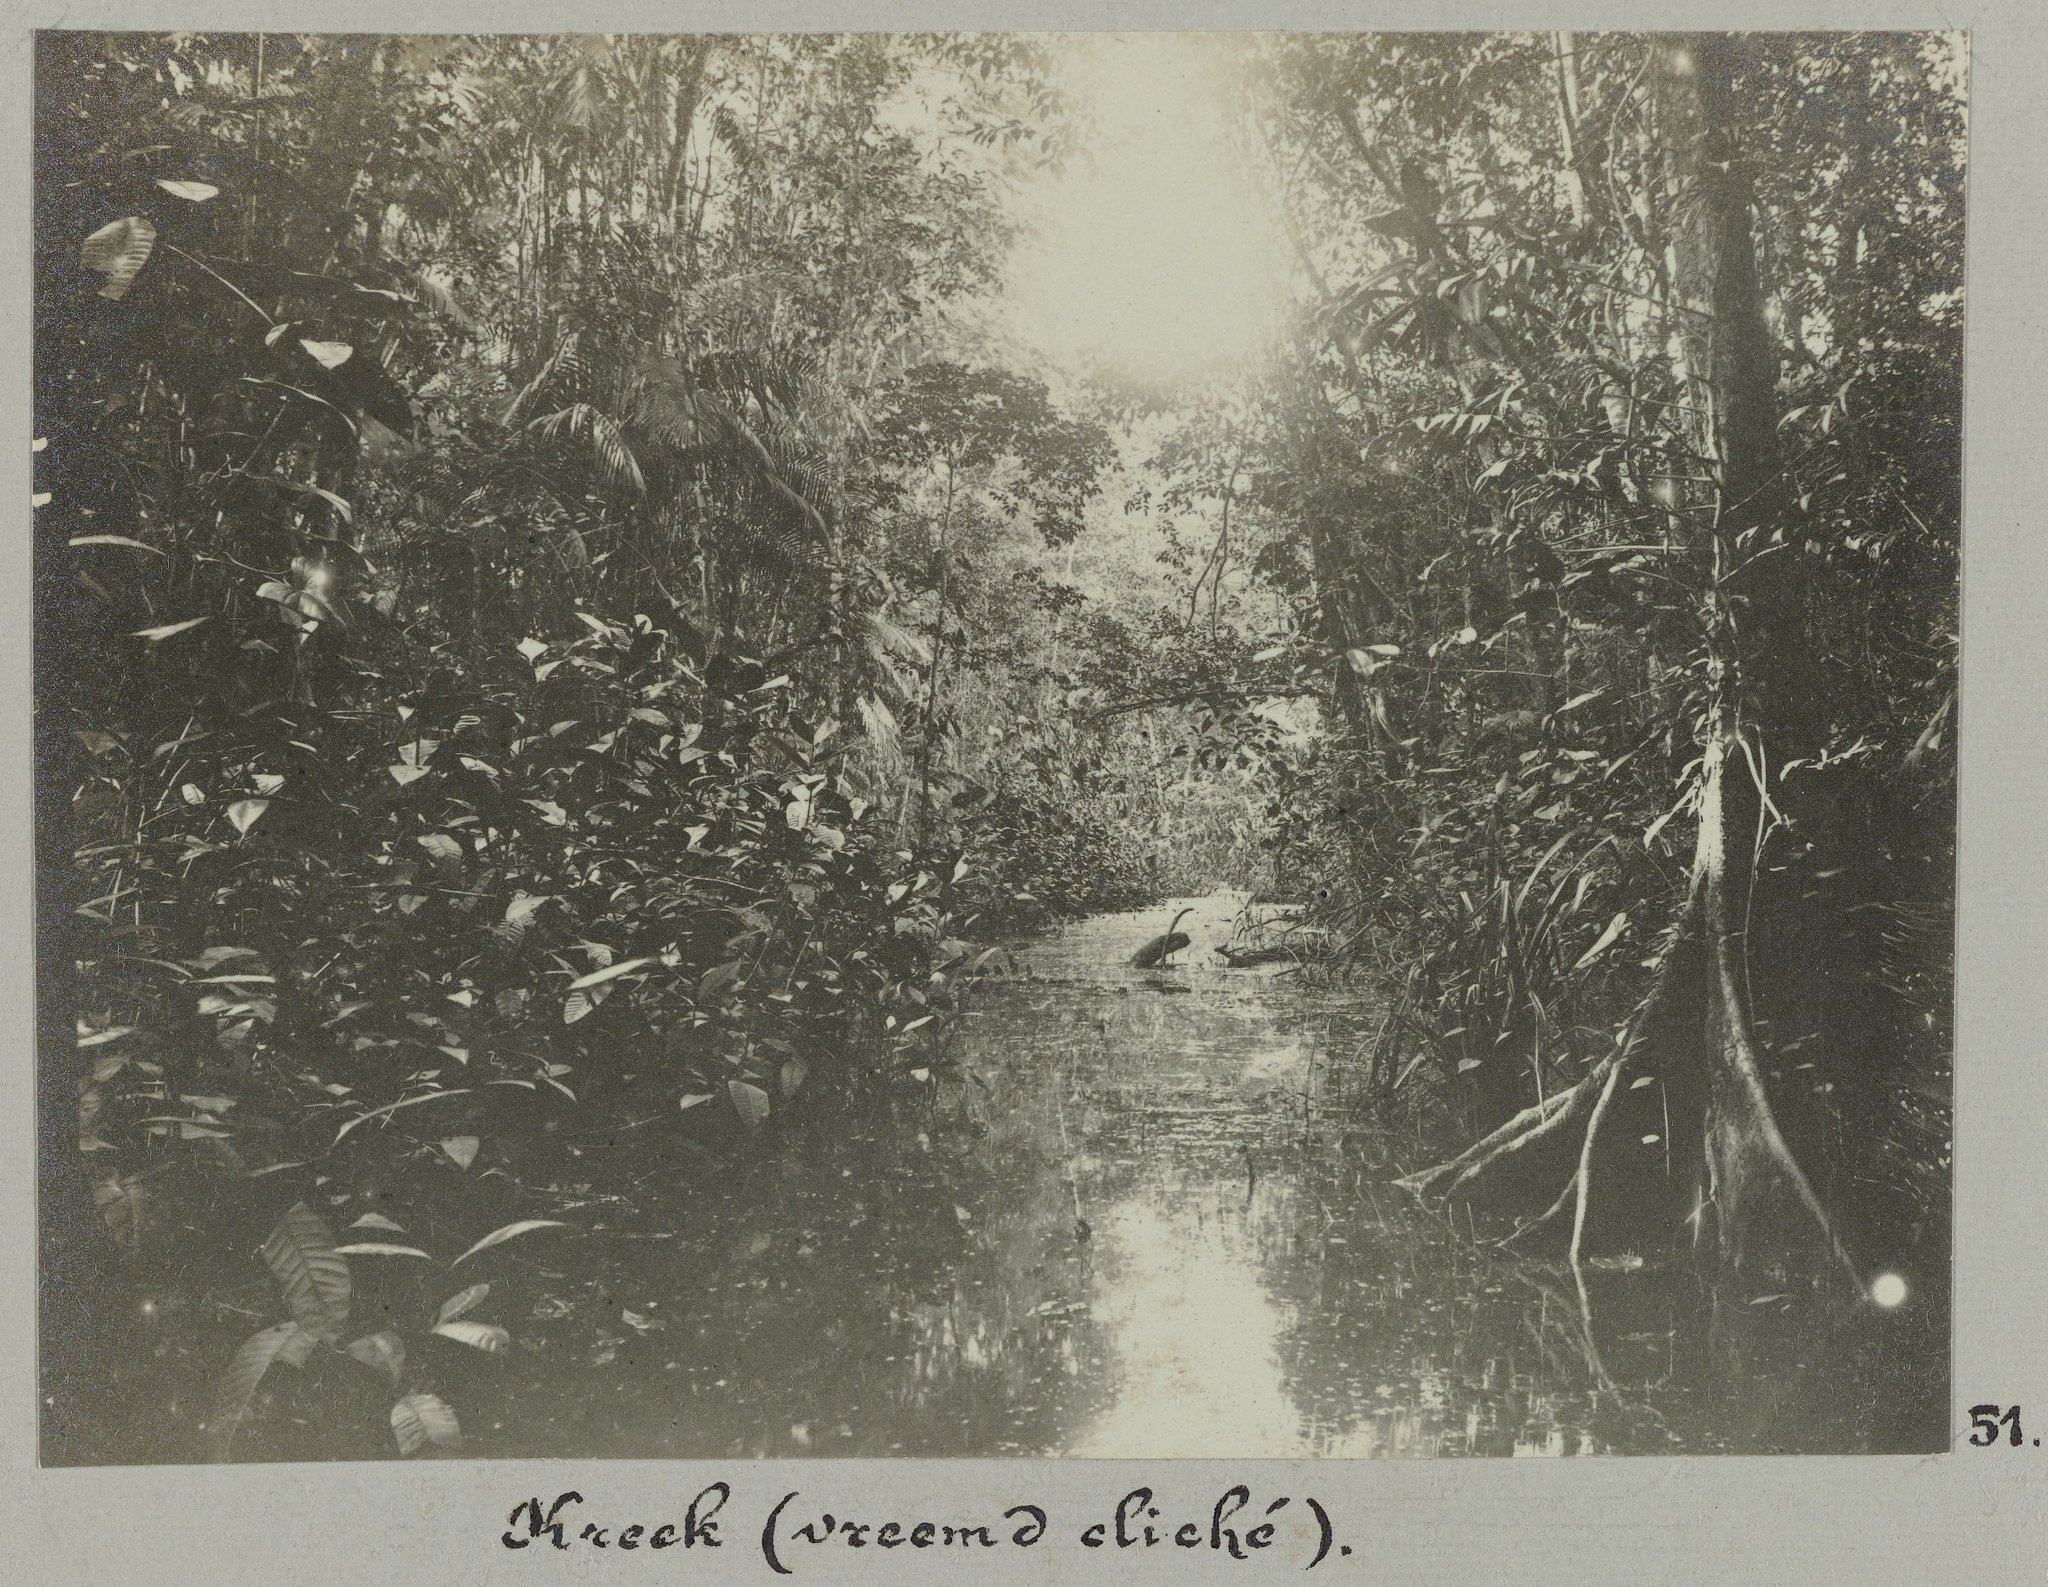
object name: photograph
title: Kreek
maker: hendrik doijer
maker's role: engineer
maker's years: 1863-1925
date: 1903-1910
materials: photographic support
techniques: gelatin silver print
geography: suriname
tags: suriname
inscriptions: inscription: ‘51. / Kreek (vreemd cliché).’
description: Kreek in het oerwoud. Onderdeel van het fotoalbum Souvenir de Voyage (deel 2), over het leven van de familie Doijer in en rond de plantage Ma Retraite in Suriname in de jaren 1903-1910.